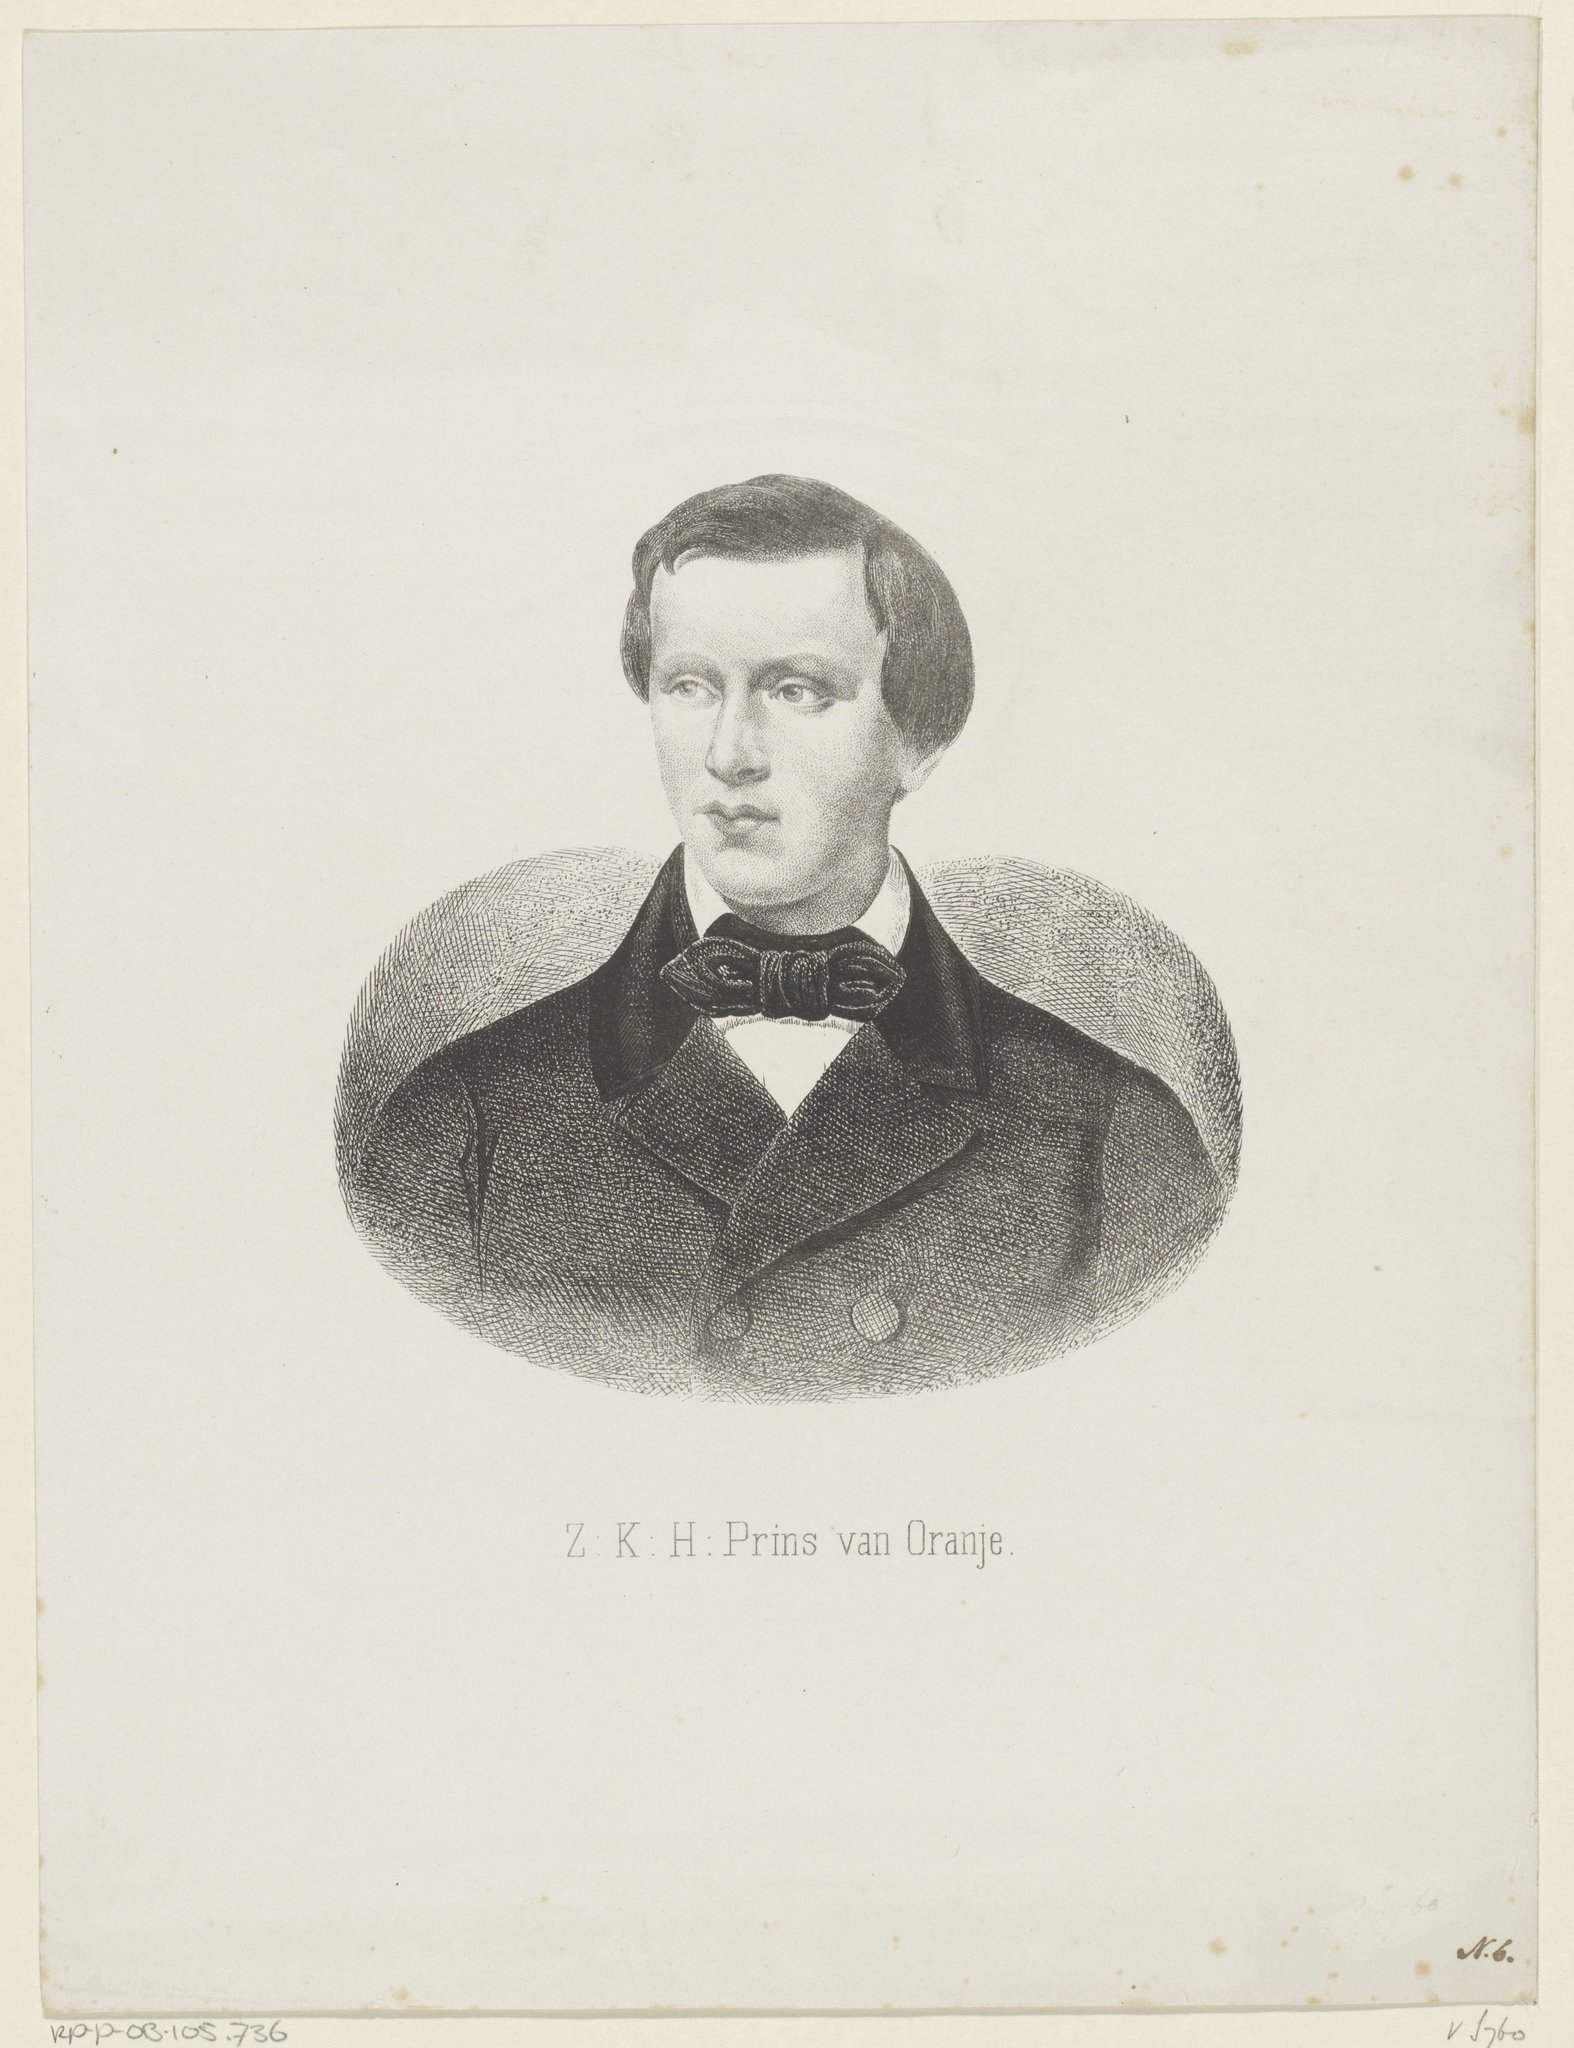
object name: print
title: Portret van Willem, prins der Nederlanden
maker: Anonymous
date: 1850-1949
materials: paper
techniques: engraving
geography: netherlands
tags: paris, willem (prins der nederlanden)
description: De hier vermelde titel verwijst naar de hoogst verkregen titel van de geportretteerde, niet per se naar de titel die de geportretteerde op deze voorstelling draagt.